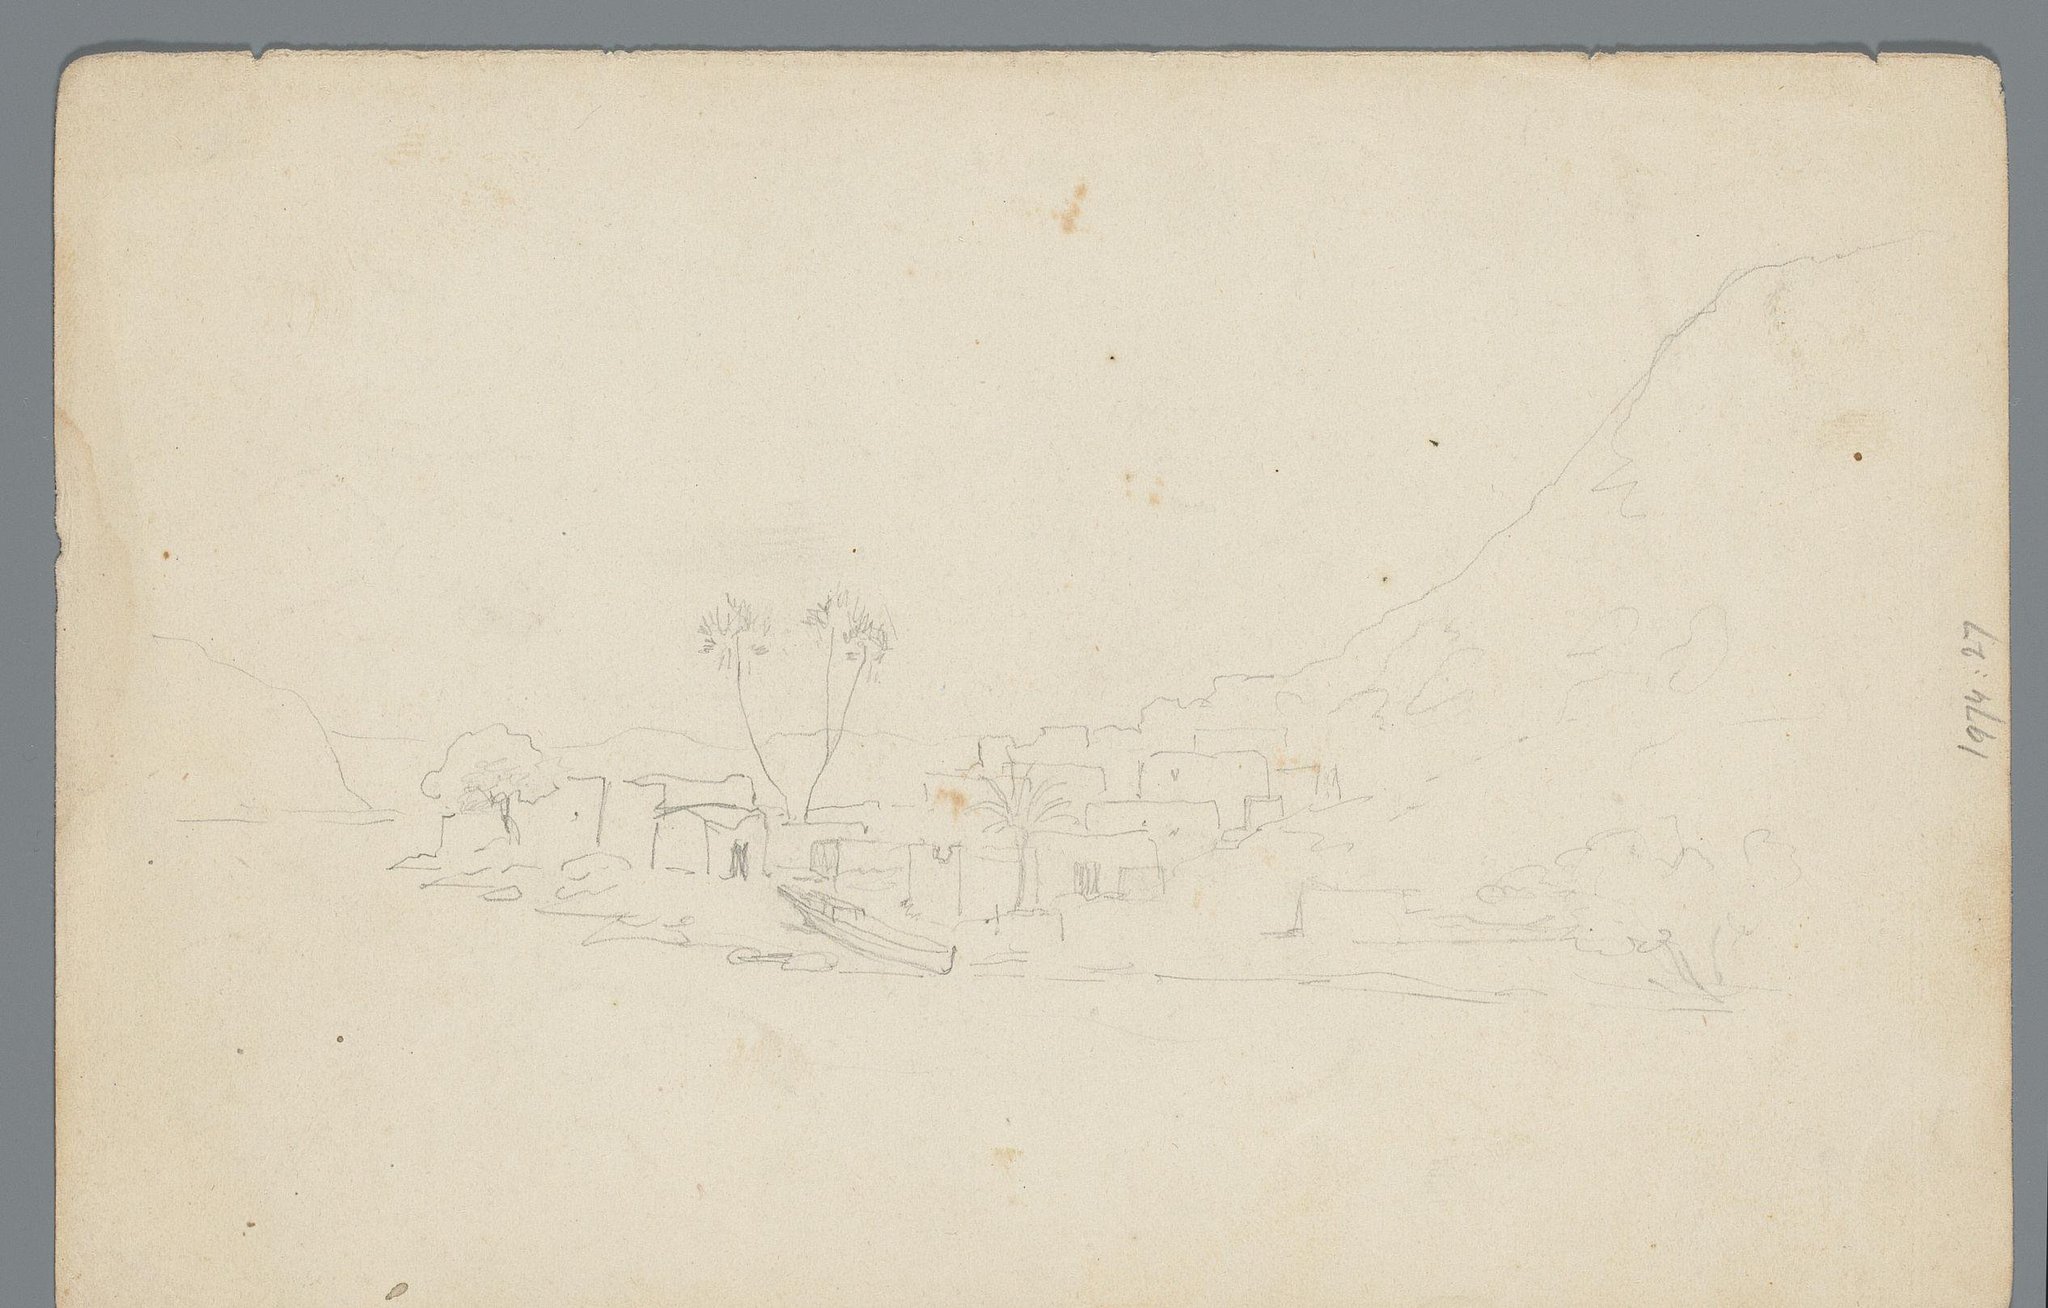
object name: drawing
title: Egyptische reis van 1858-1859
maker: willem de famars testas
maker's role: draughtsman, painter, print maker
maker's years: 1834-1896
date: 1858-1859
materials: paper, pencil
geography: egypt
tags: oasis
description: Onderdeel van 20 losse bladen met tekeningen gemaakt tijdens Famars Testas zijn Egyptische reis van 1858, met voornamelijk figuren en dorpsgezichten met notities.